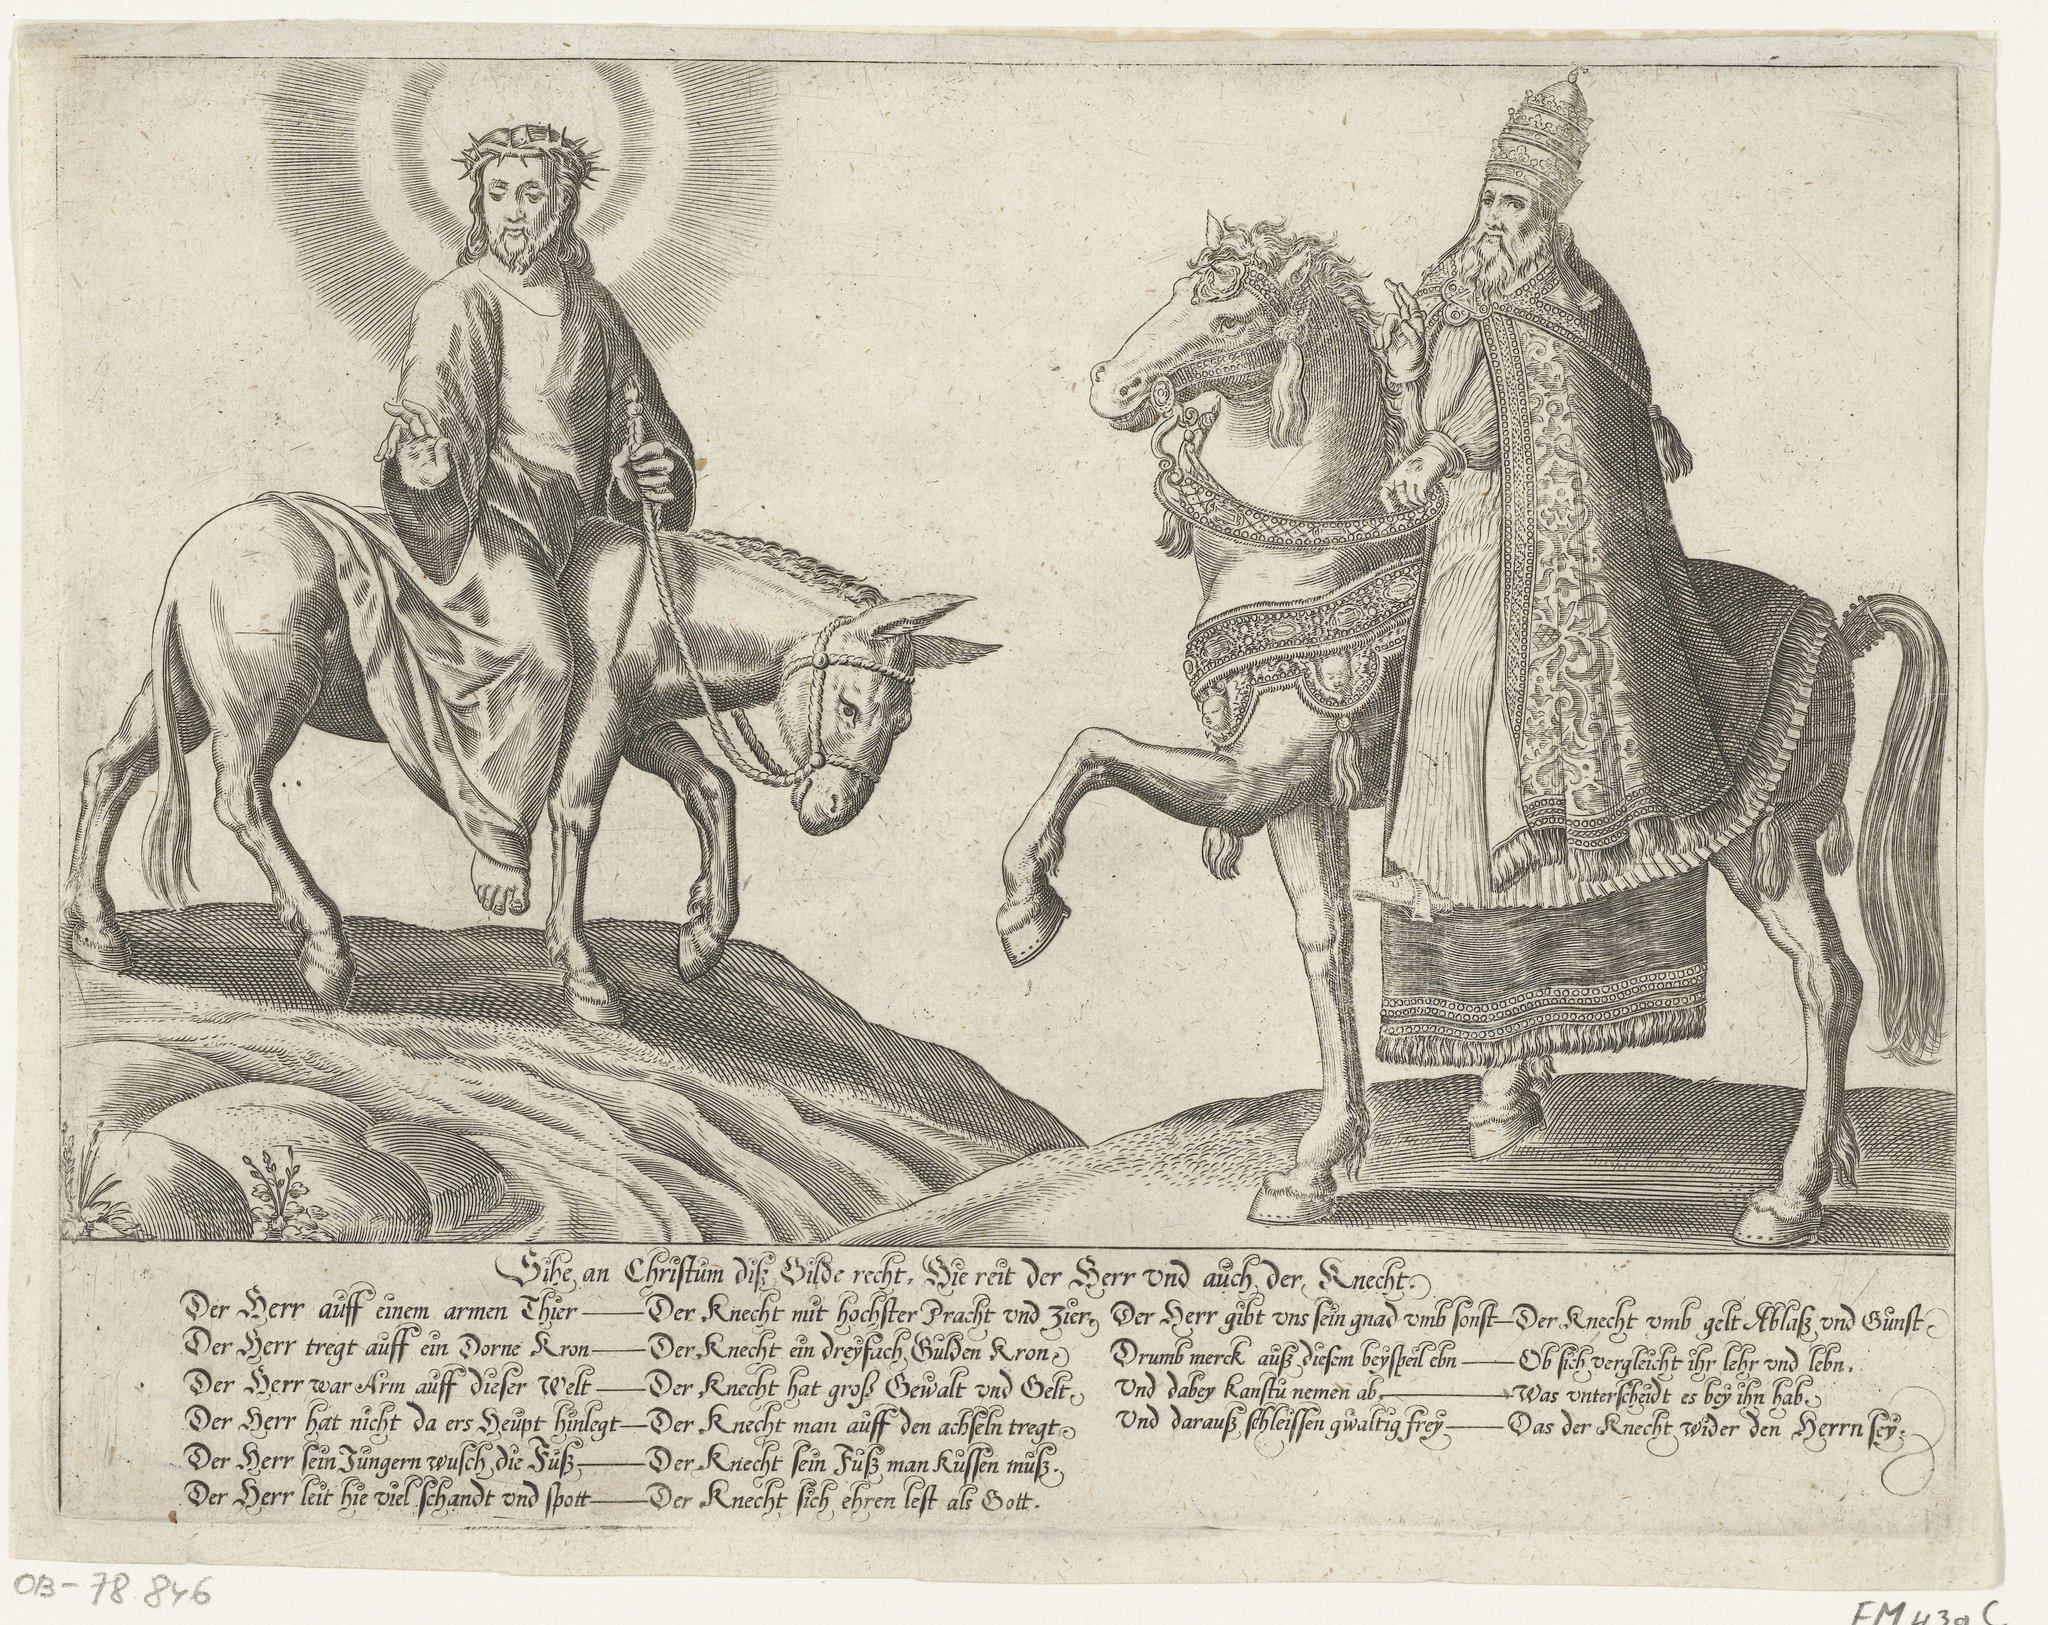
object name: print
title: Christus op de ezel, de paus te paard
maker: Anonymous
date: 1600-1624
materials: paper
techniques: engraving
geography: germany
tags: reformation (roman catholic church vs. protestantism), the pope on horseback, and christ on an ass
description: Christus op de ezel, de paus te paard. Vergelijking tussen de nederigheid van Christus en de hoogmoed van de paus. Met onderschrift van 2 keer 2 kolommen van elk 6 en 4 regels in het Duits waarin de verschillen tussen Christus en de paus worden benoemd. Spotprent op de paus en de Roomse kerk, thematiek van ca. 1560.